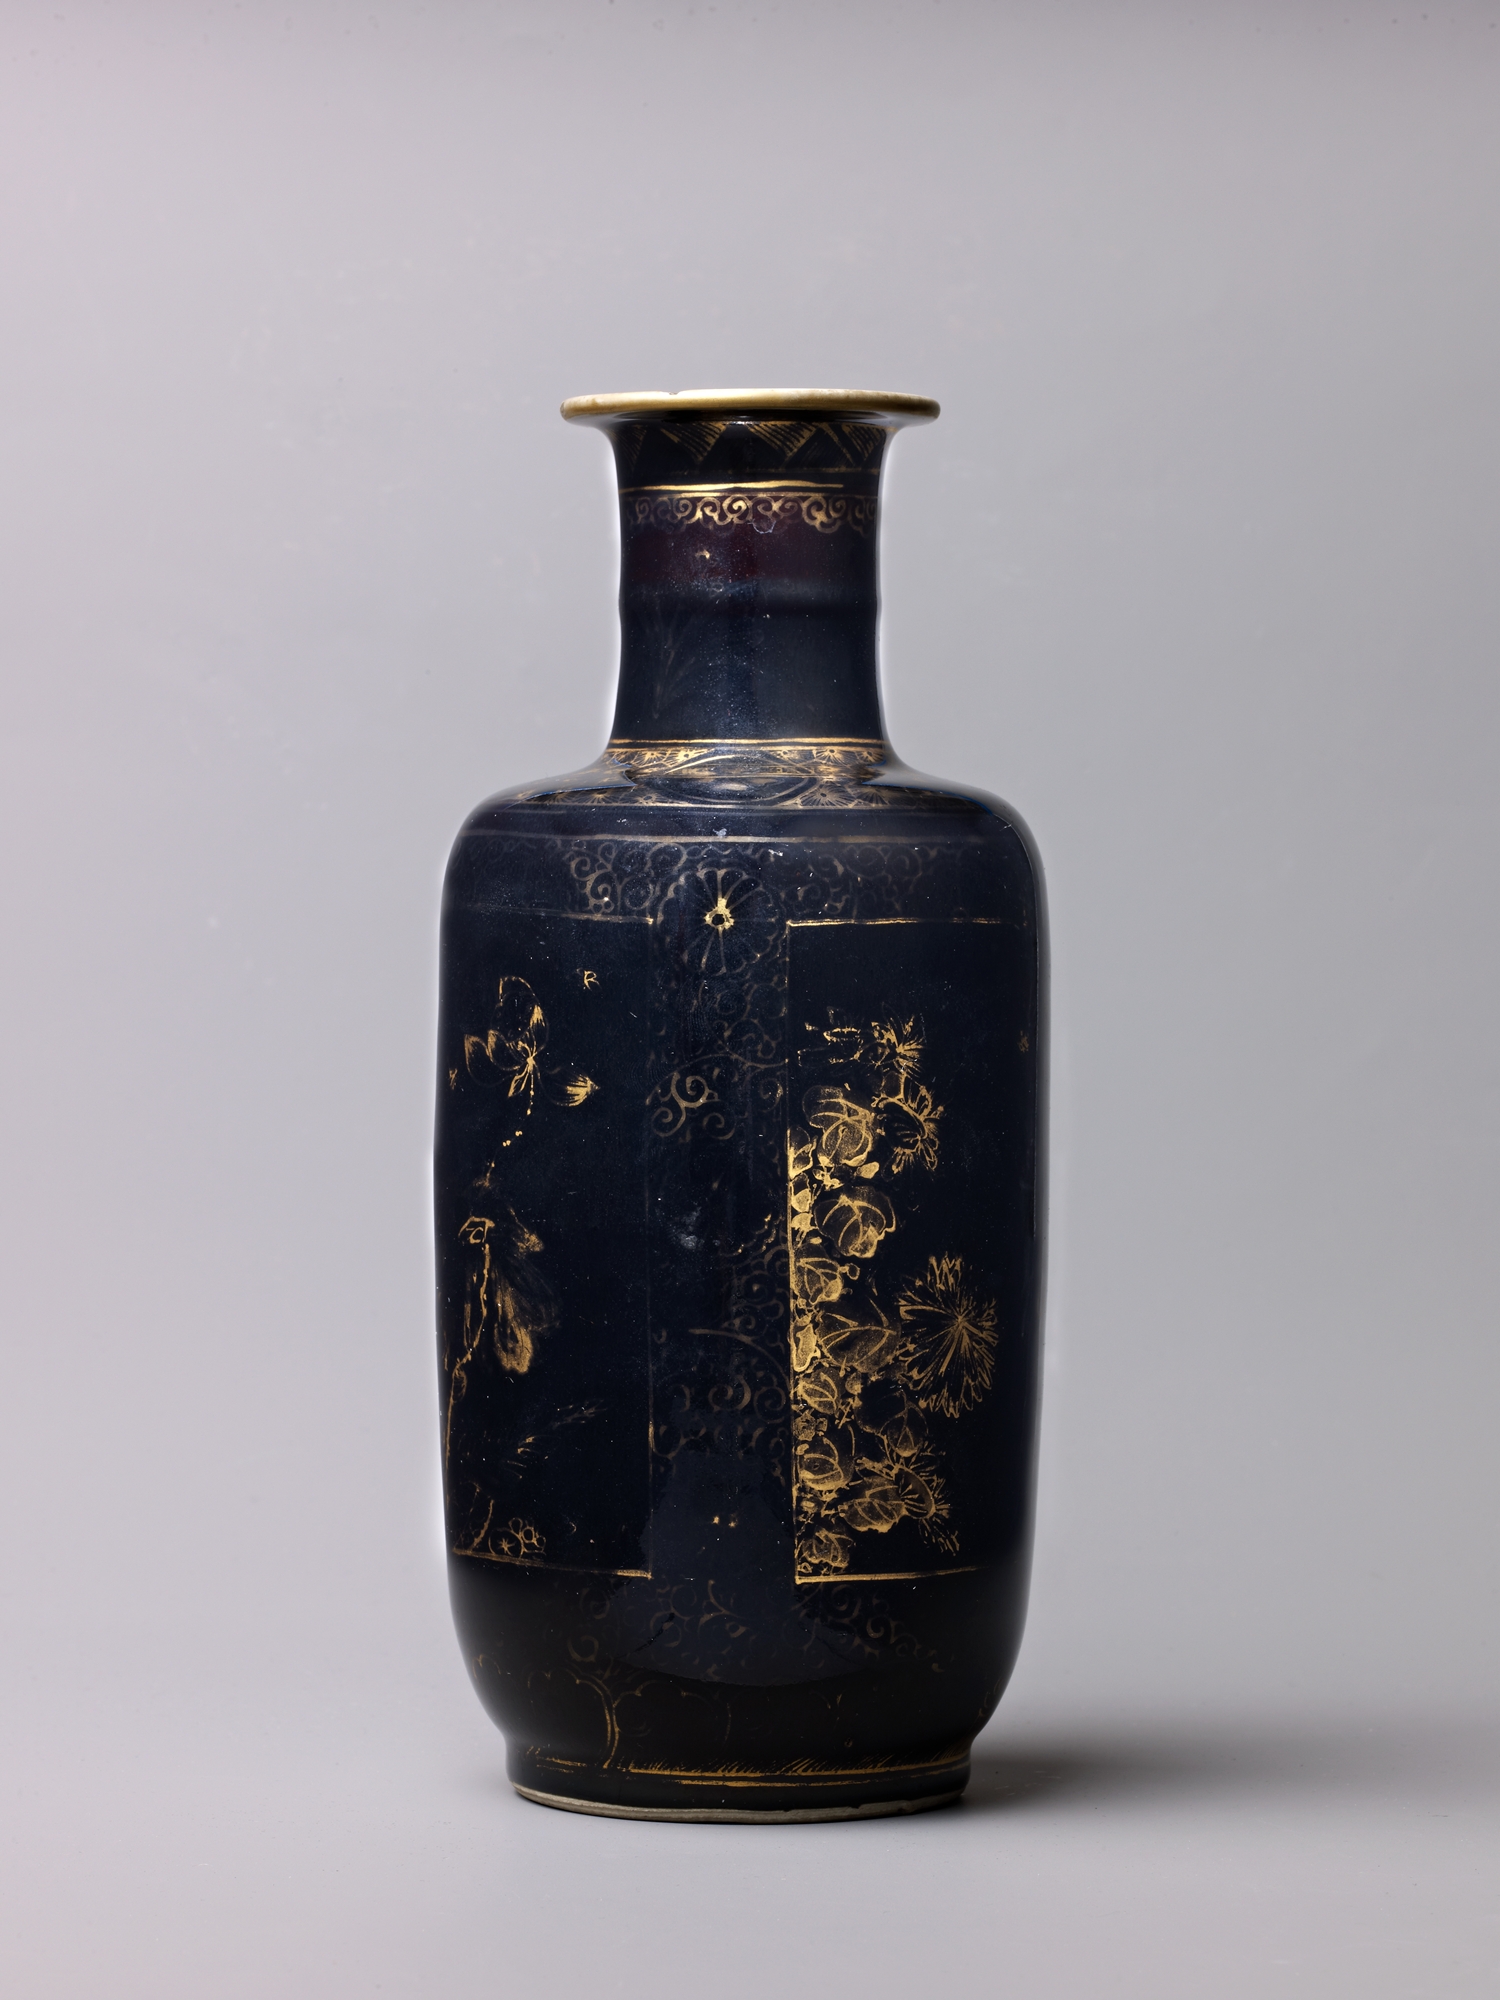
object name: vase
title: Club-shaped vase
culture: chinese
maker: chinese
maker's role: artist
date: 1662-1722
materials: gilt, glaze, porcelain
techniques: overglaze, painting